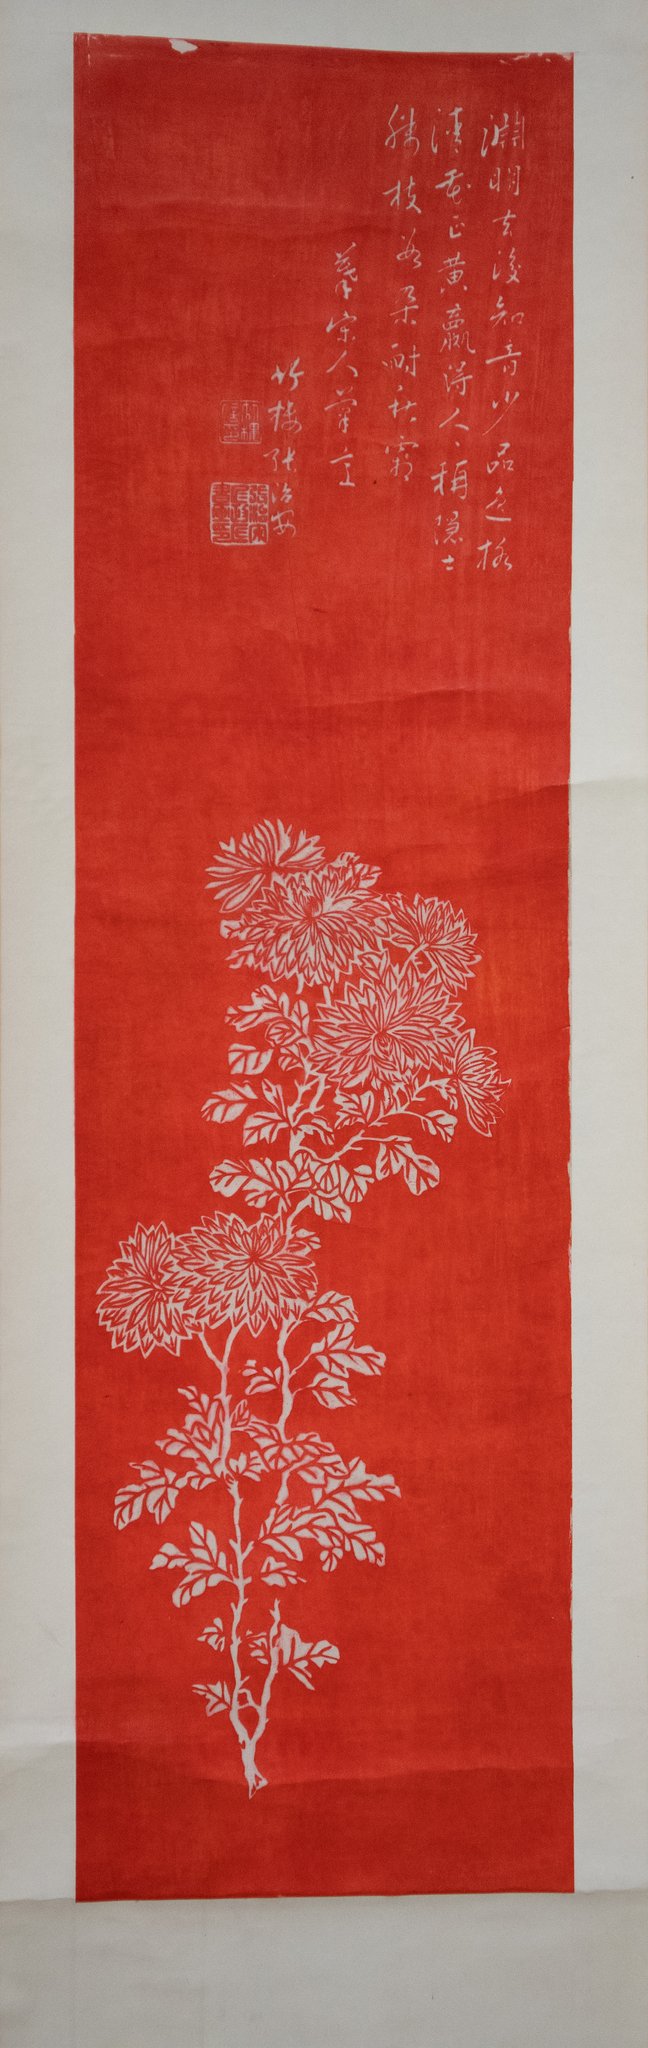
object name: print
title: Chrysanthemum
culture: chinese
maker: kuang xü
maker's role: artist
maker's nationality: chinese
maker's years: 1874-1909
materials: ink, paper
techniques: polychrome, woodblock print